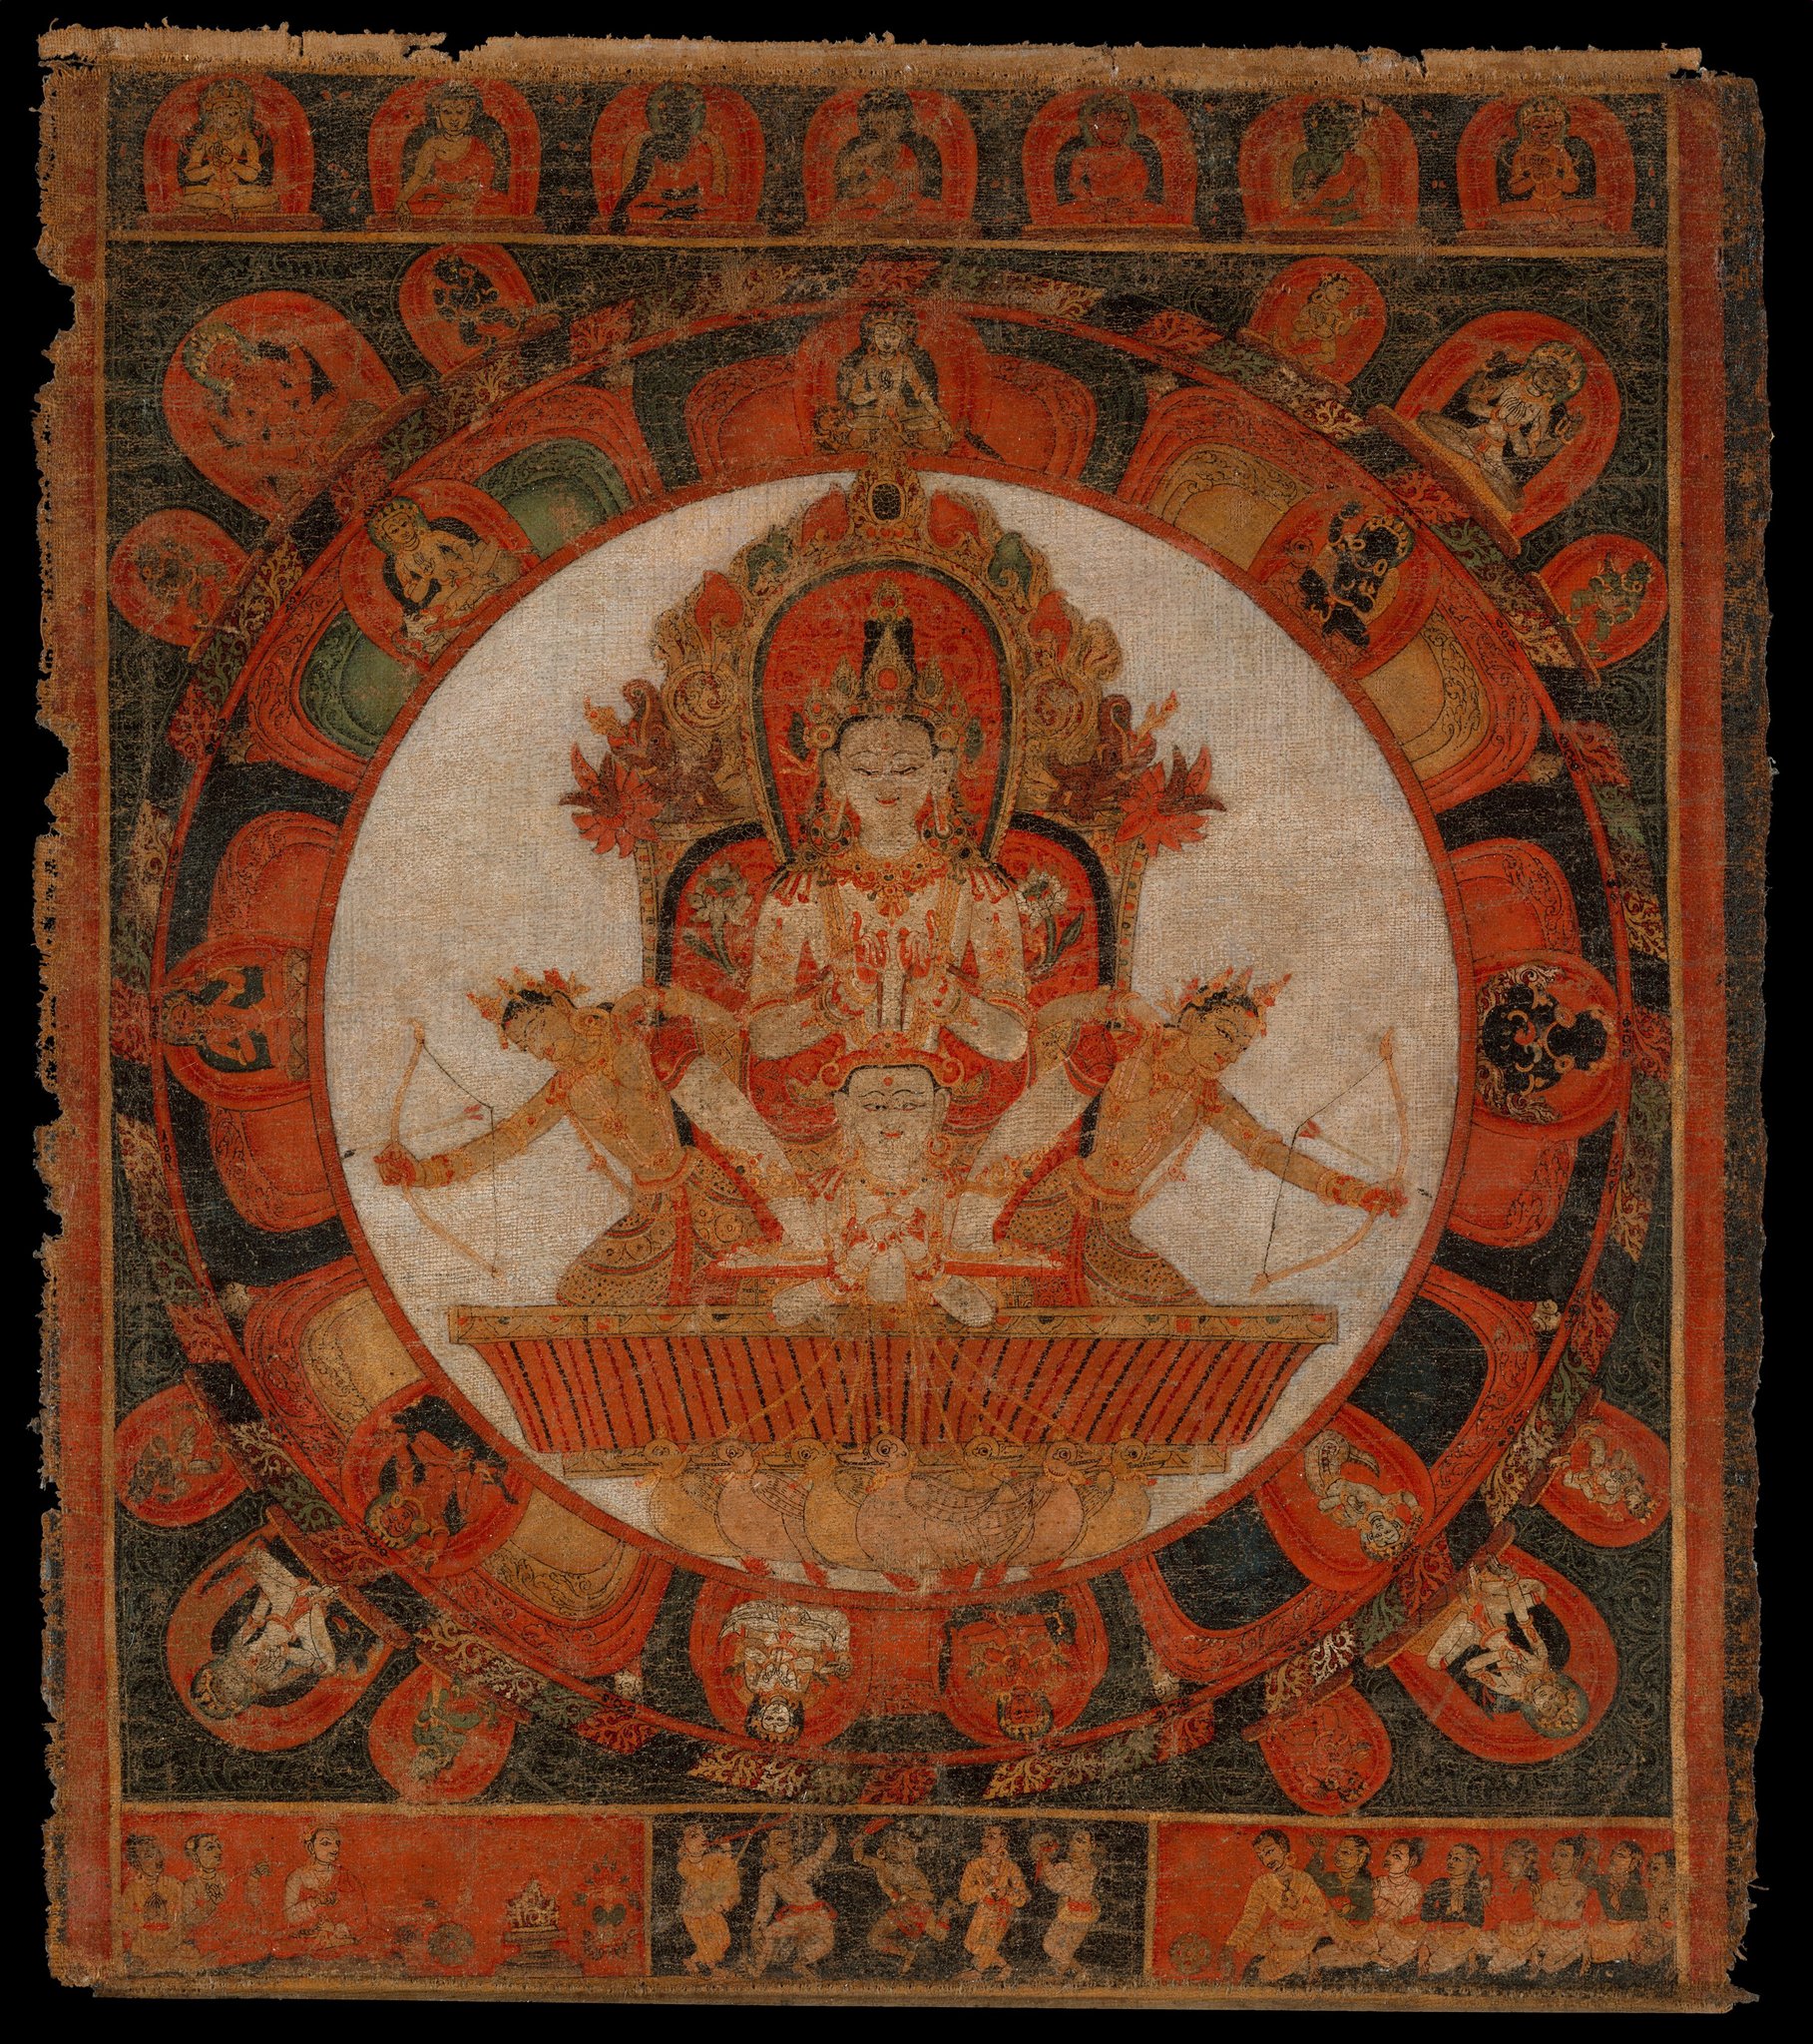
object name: thangka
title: Mandala of Chandra, God of the Moon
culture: nepali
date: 1367-1433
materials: textile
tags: geese,buddhism,bodhisattvas,buddha,chariots